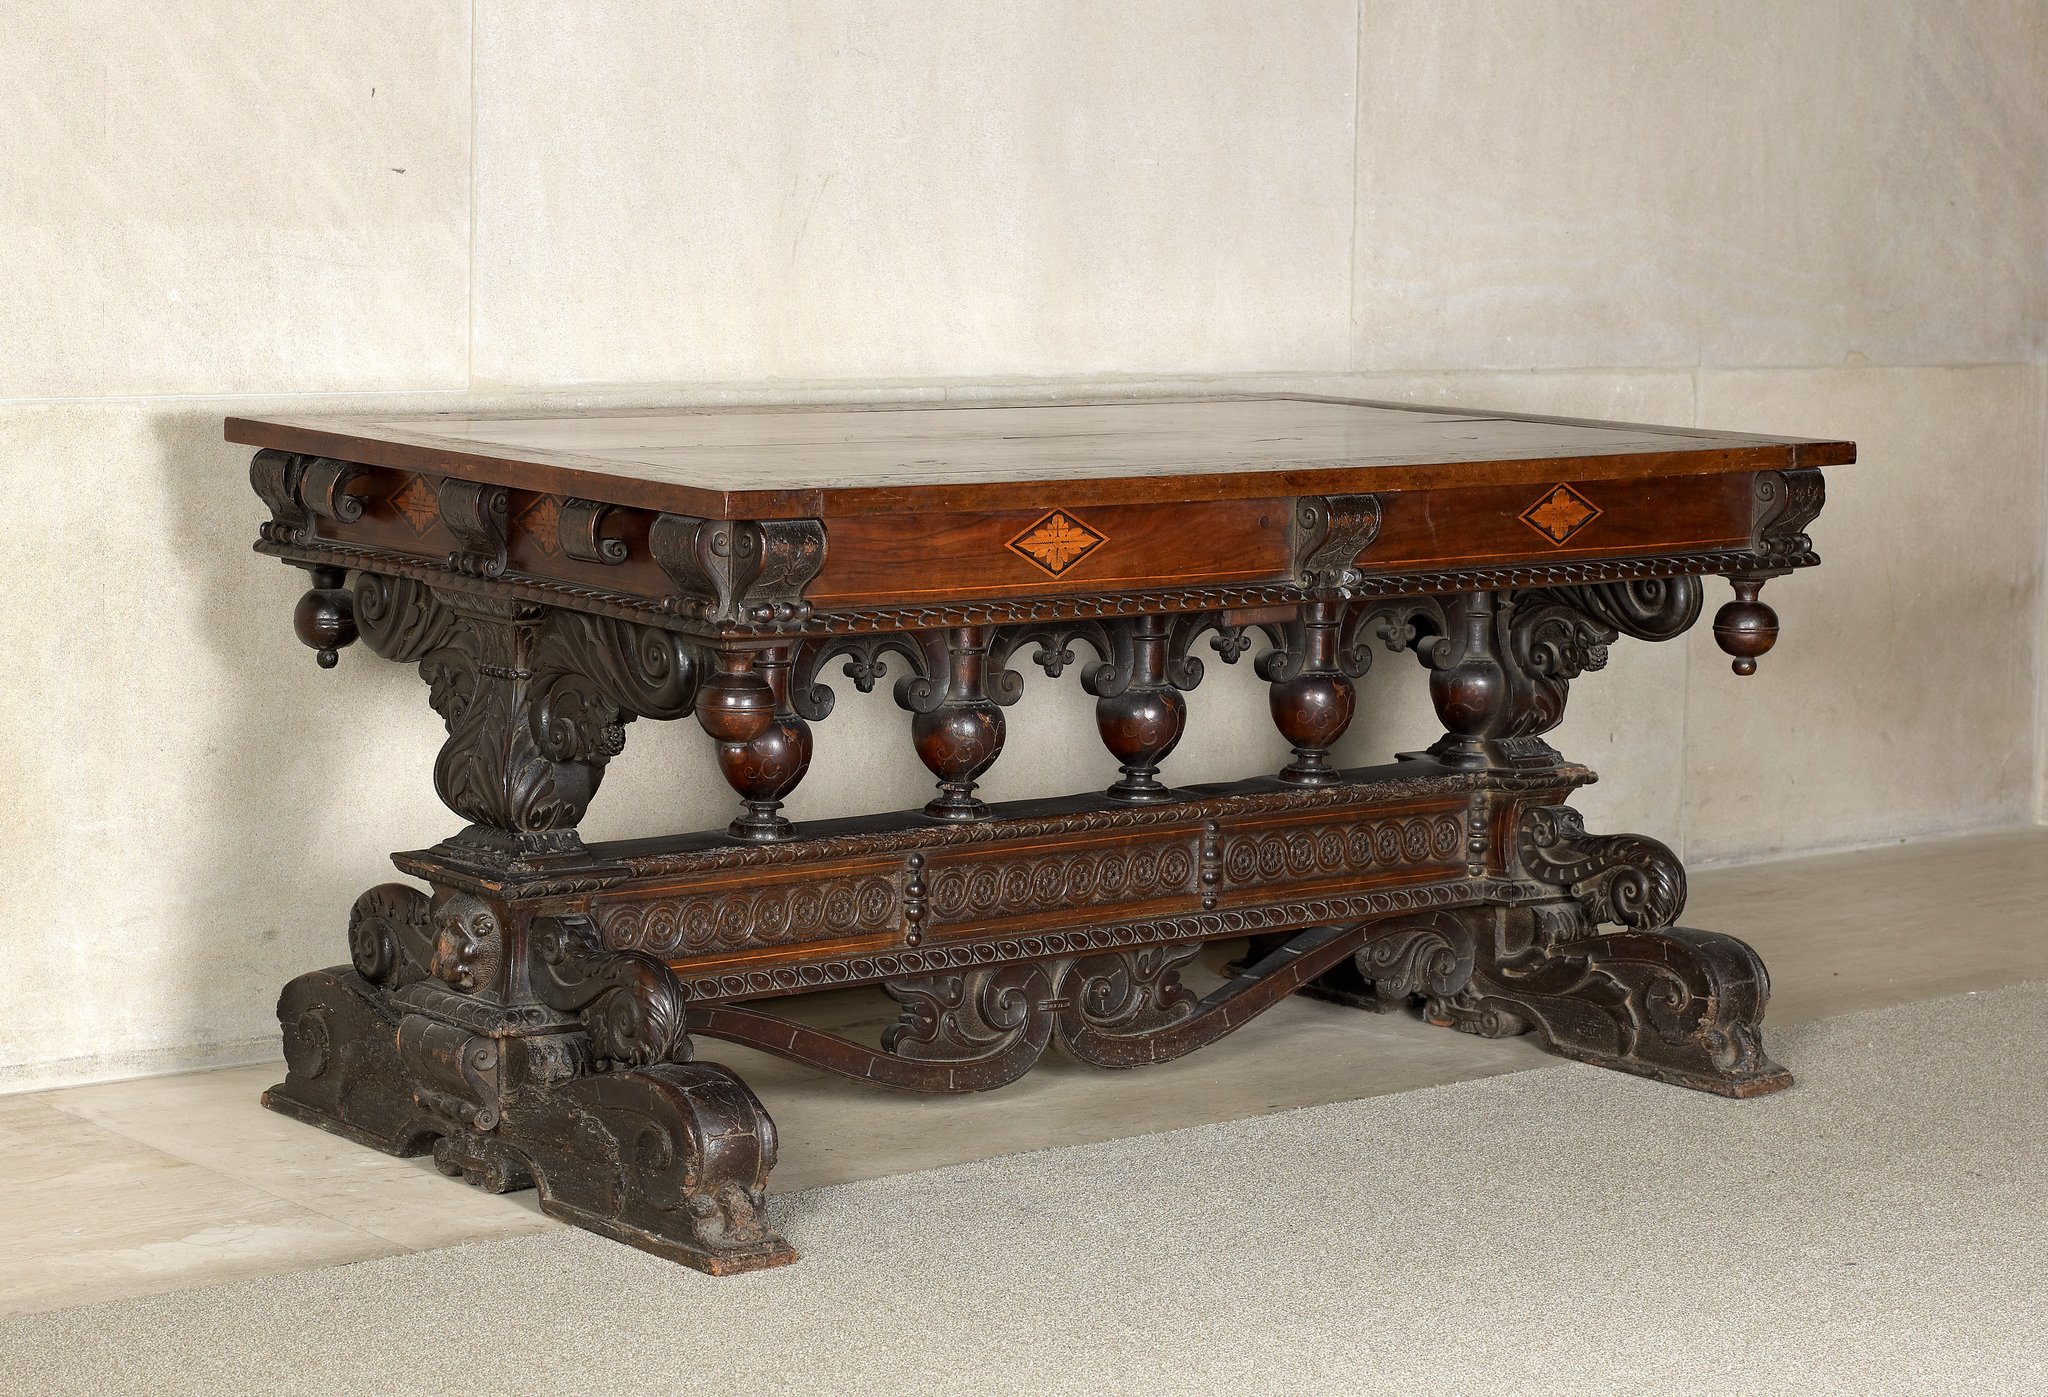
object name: table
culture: american or italian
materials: wood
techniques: carving, inlay, stain